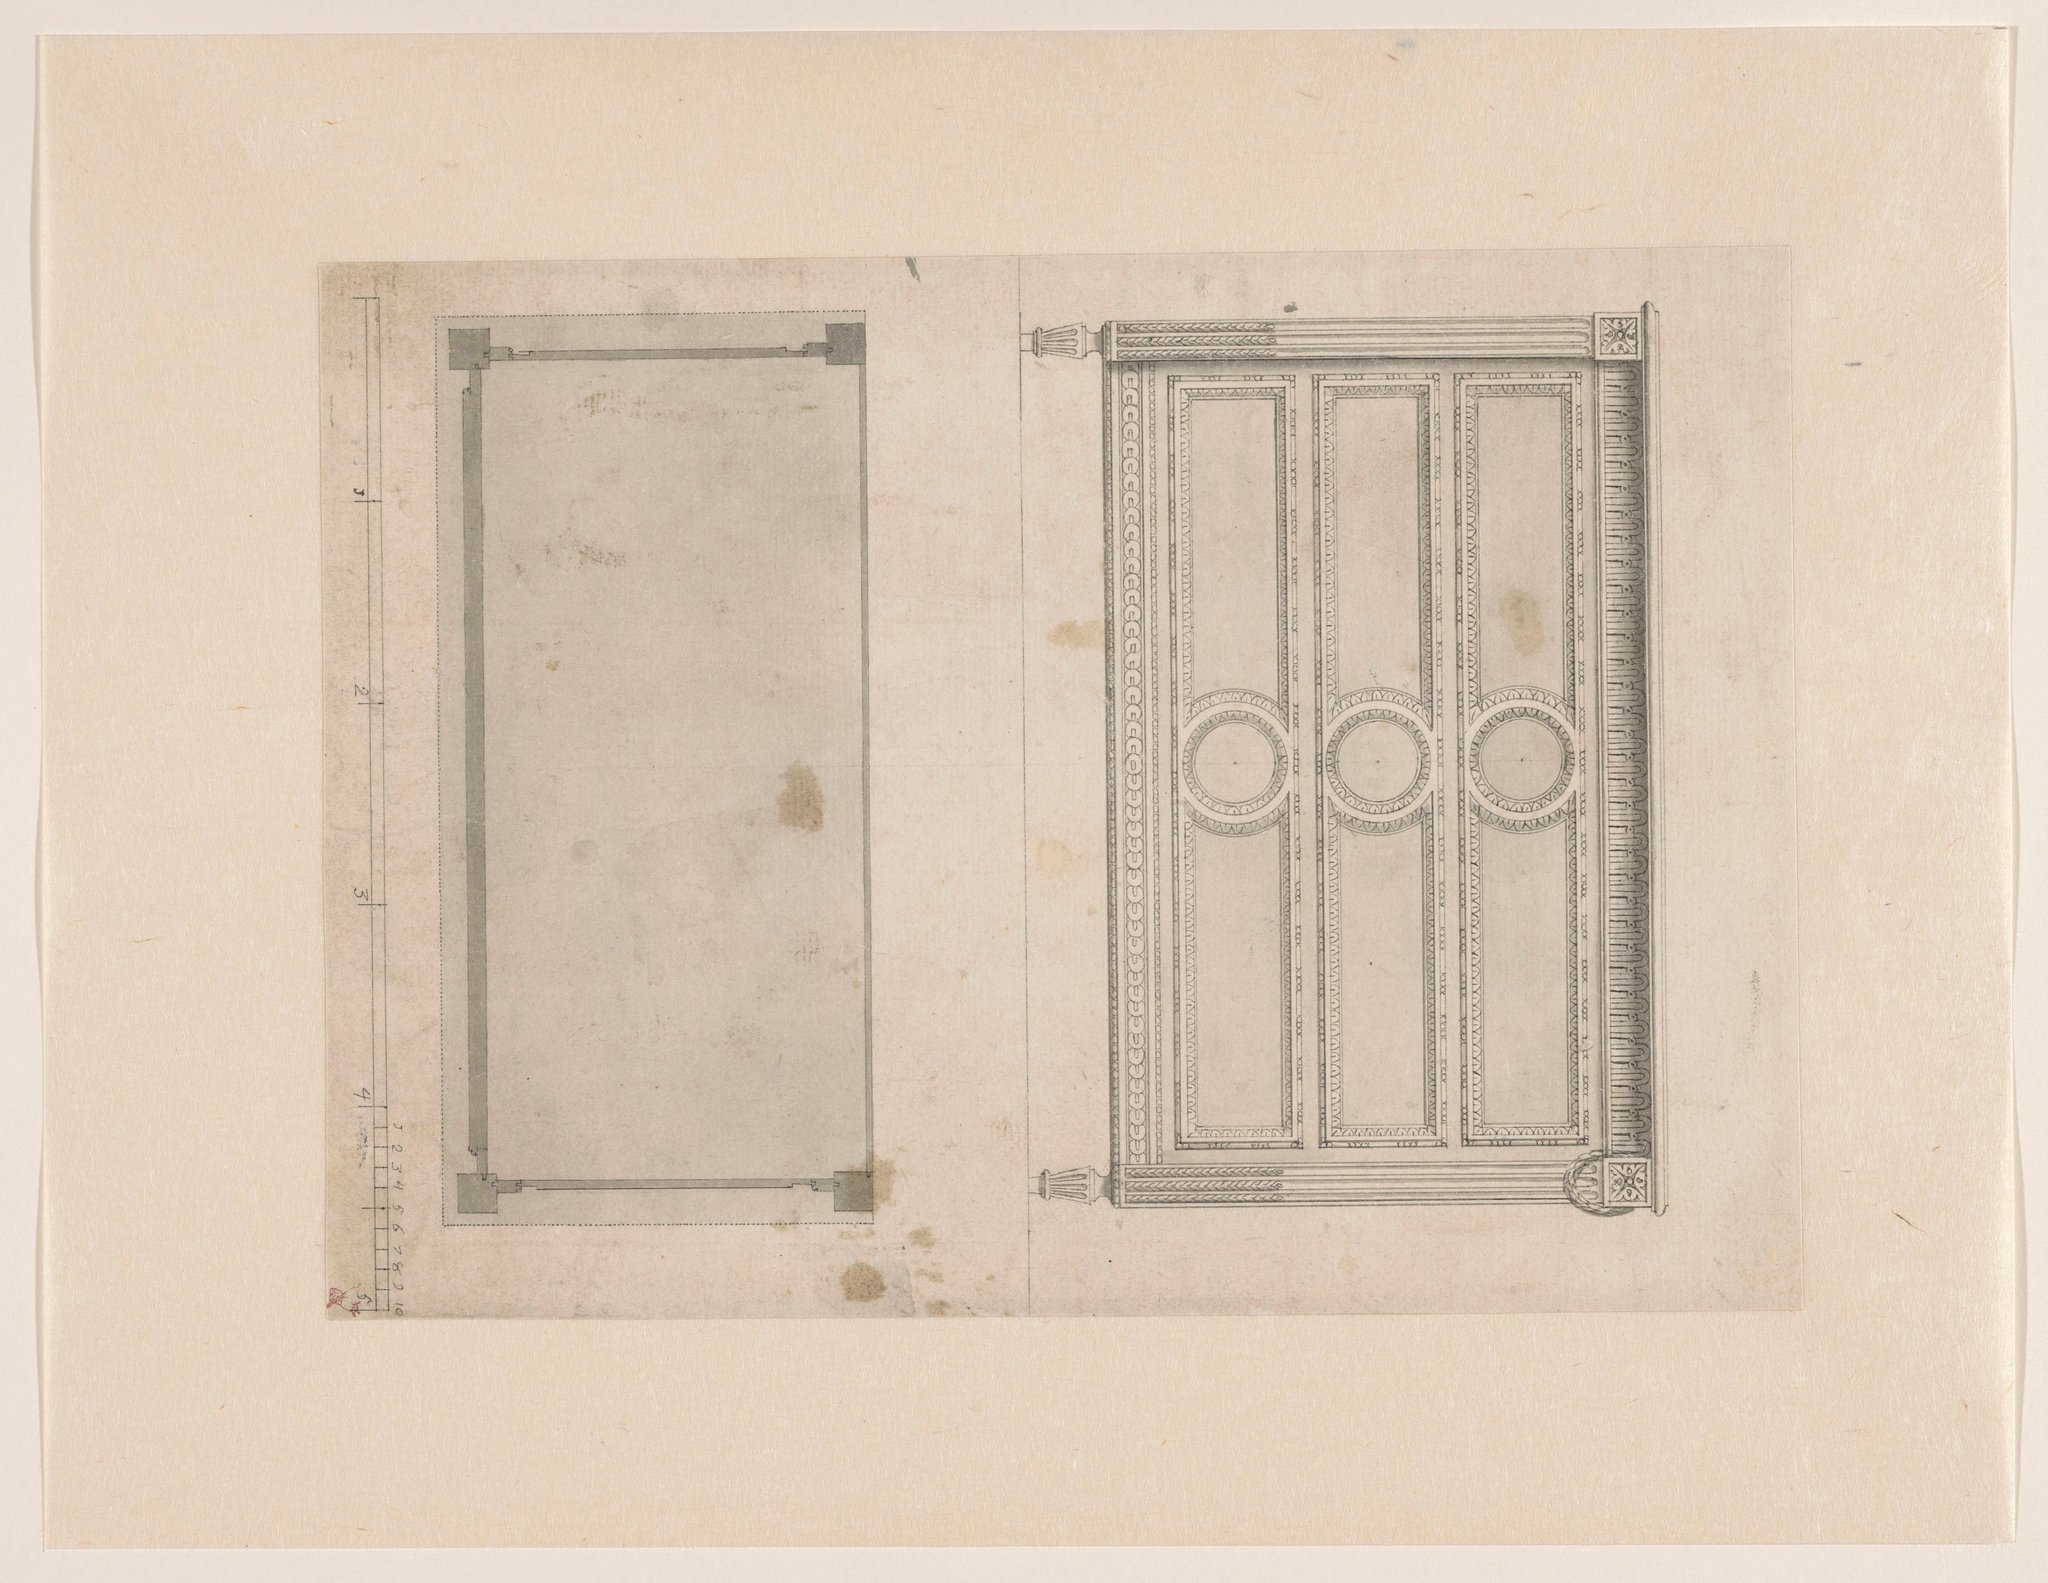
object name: design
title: Ontwerp voor een commode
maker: Anonymous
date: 1775-1785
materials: ink, paper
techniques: brush, pen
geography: northern netherlands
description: Ontwerp voor een commode. Met plattegrond en opstand; onderaan maataanduiding.